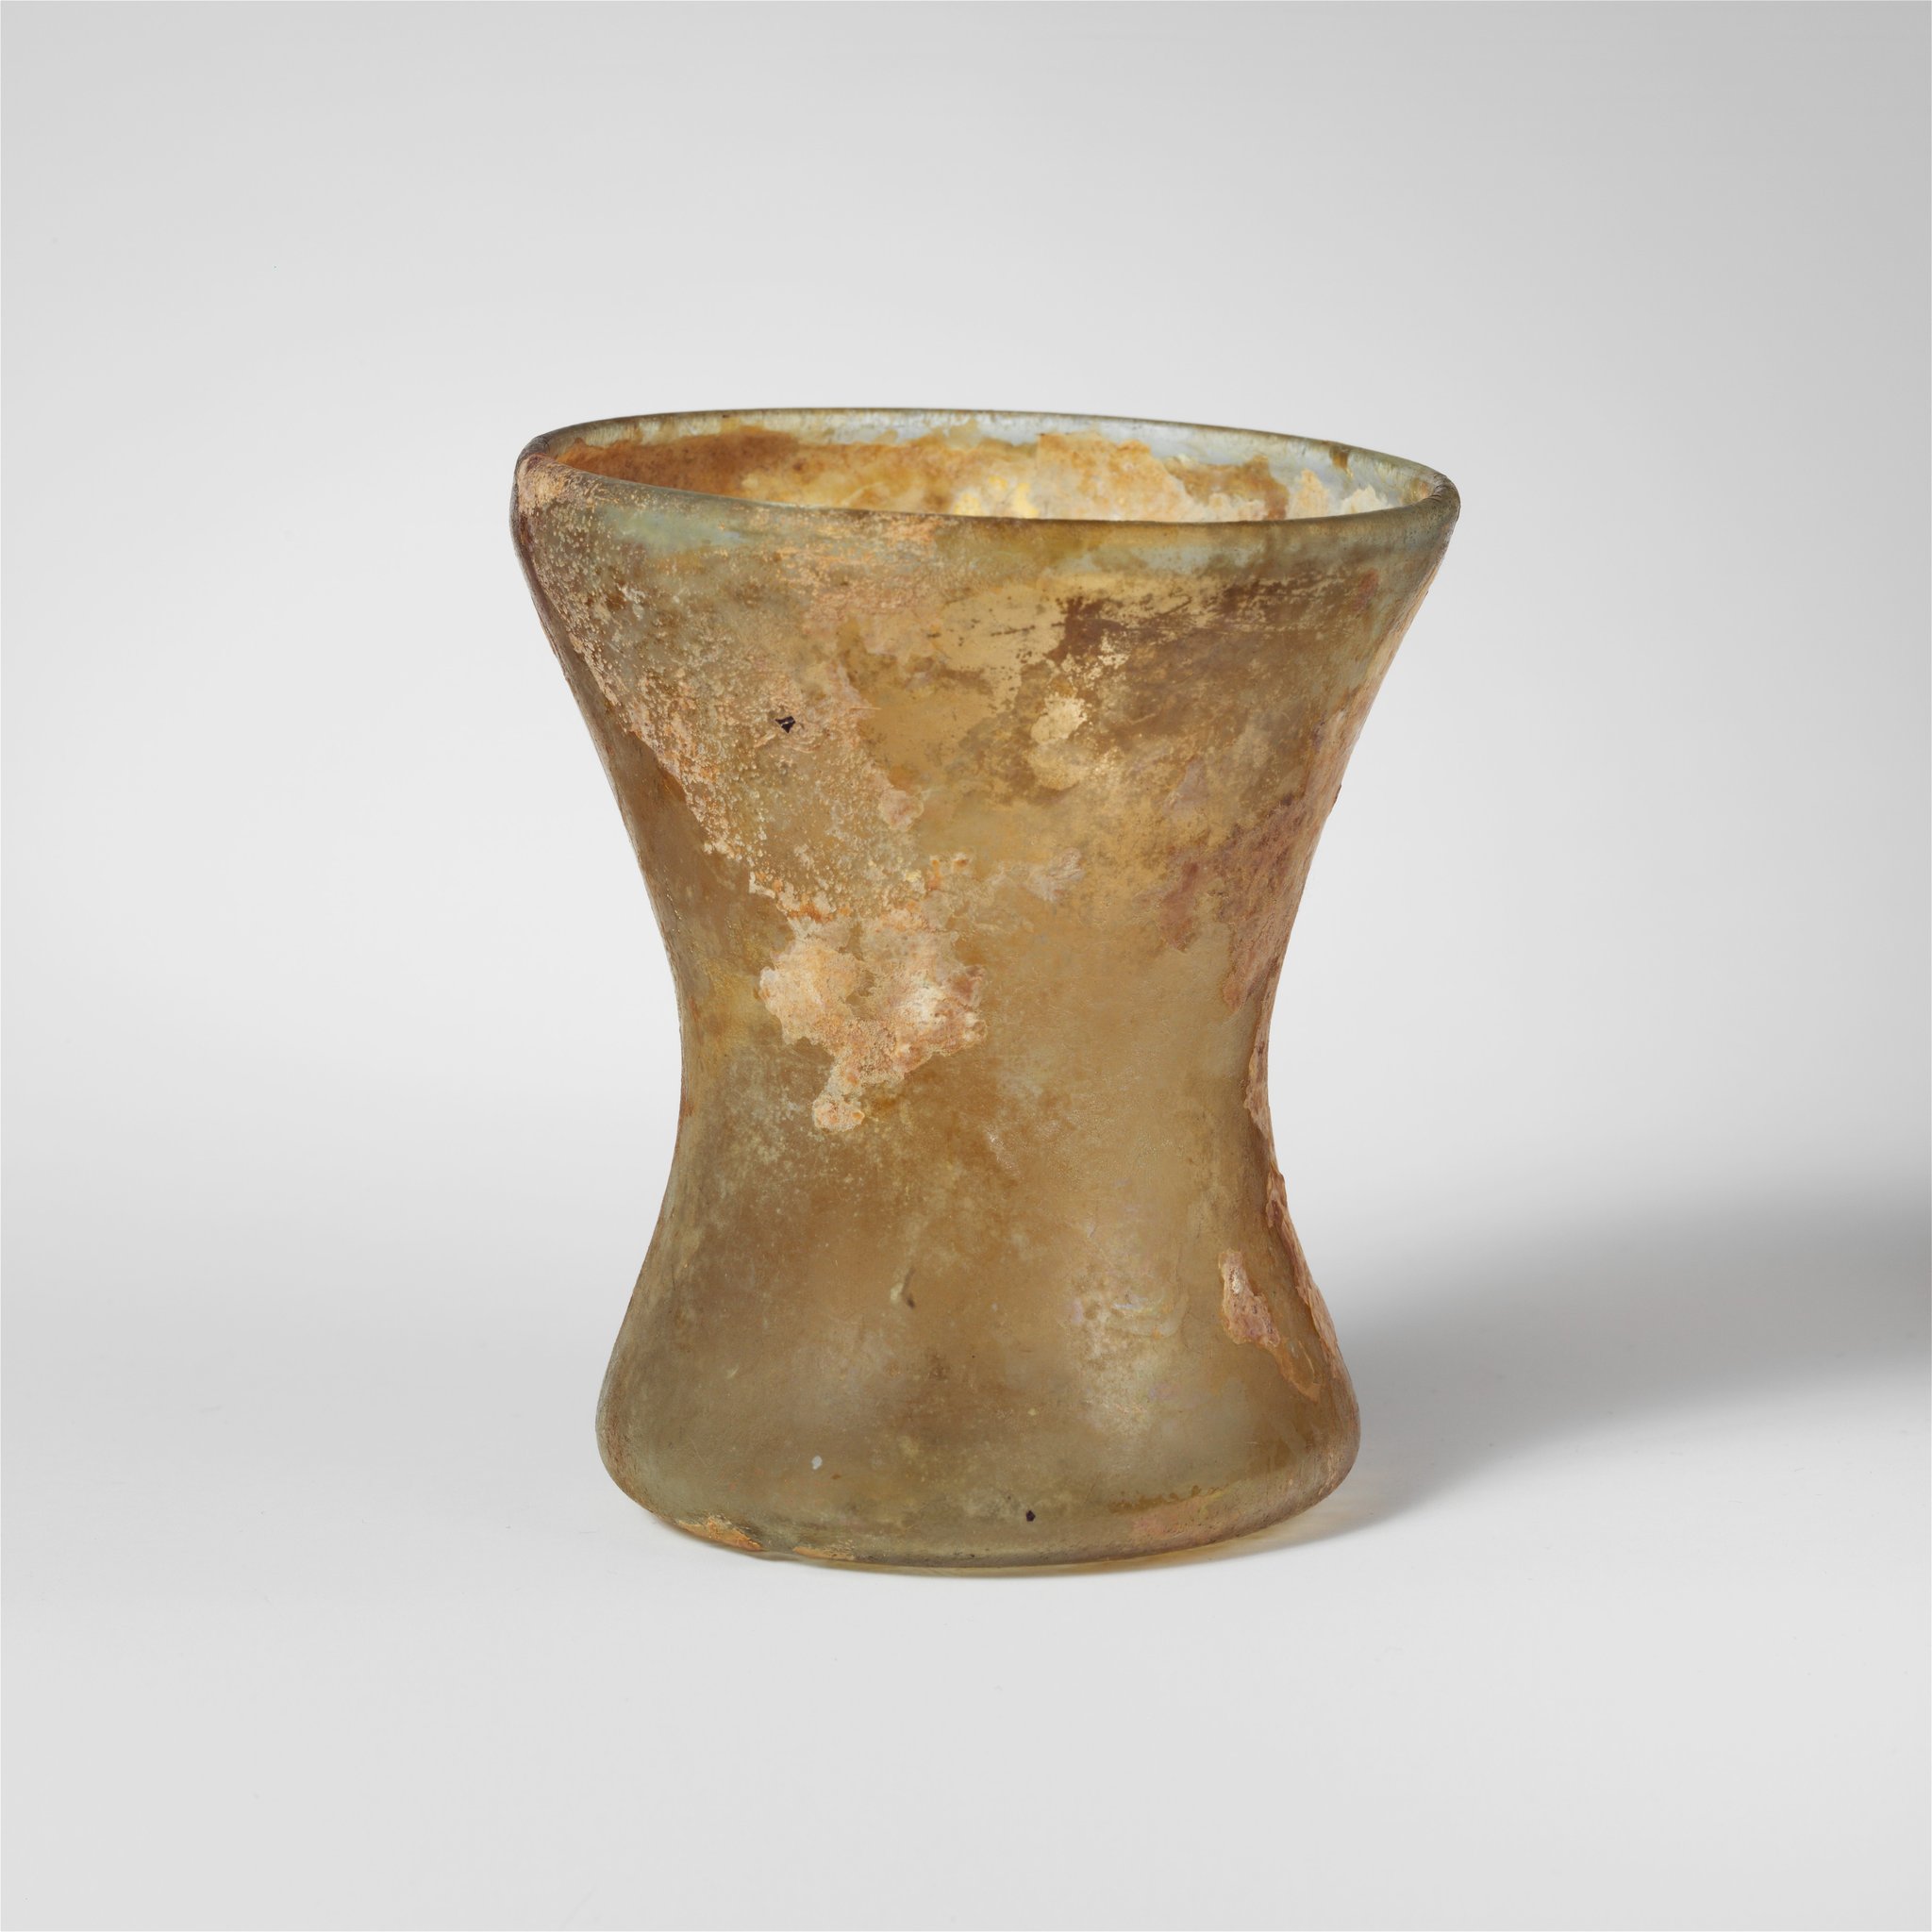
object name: beaker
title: Glass beaker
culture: roman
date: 101-300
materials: glass